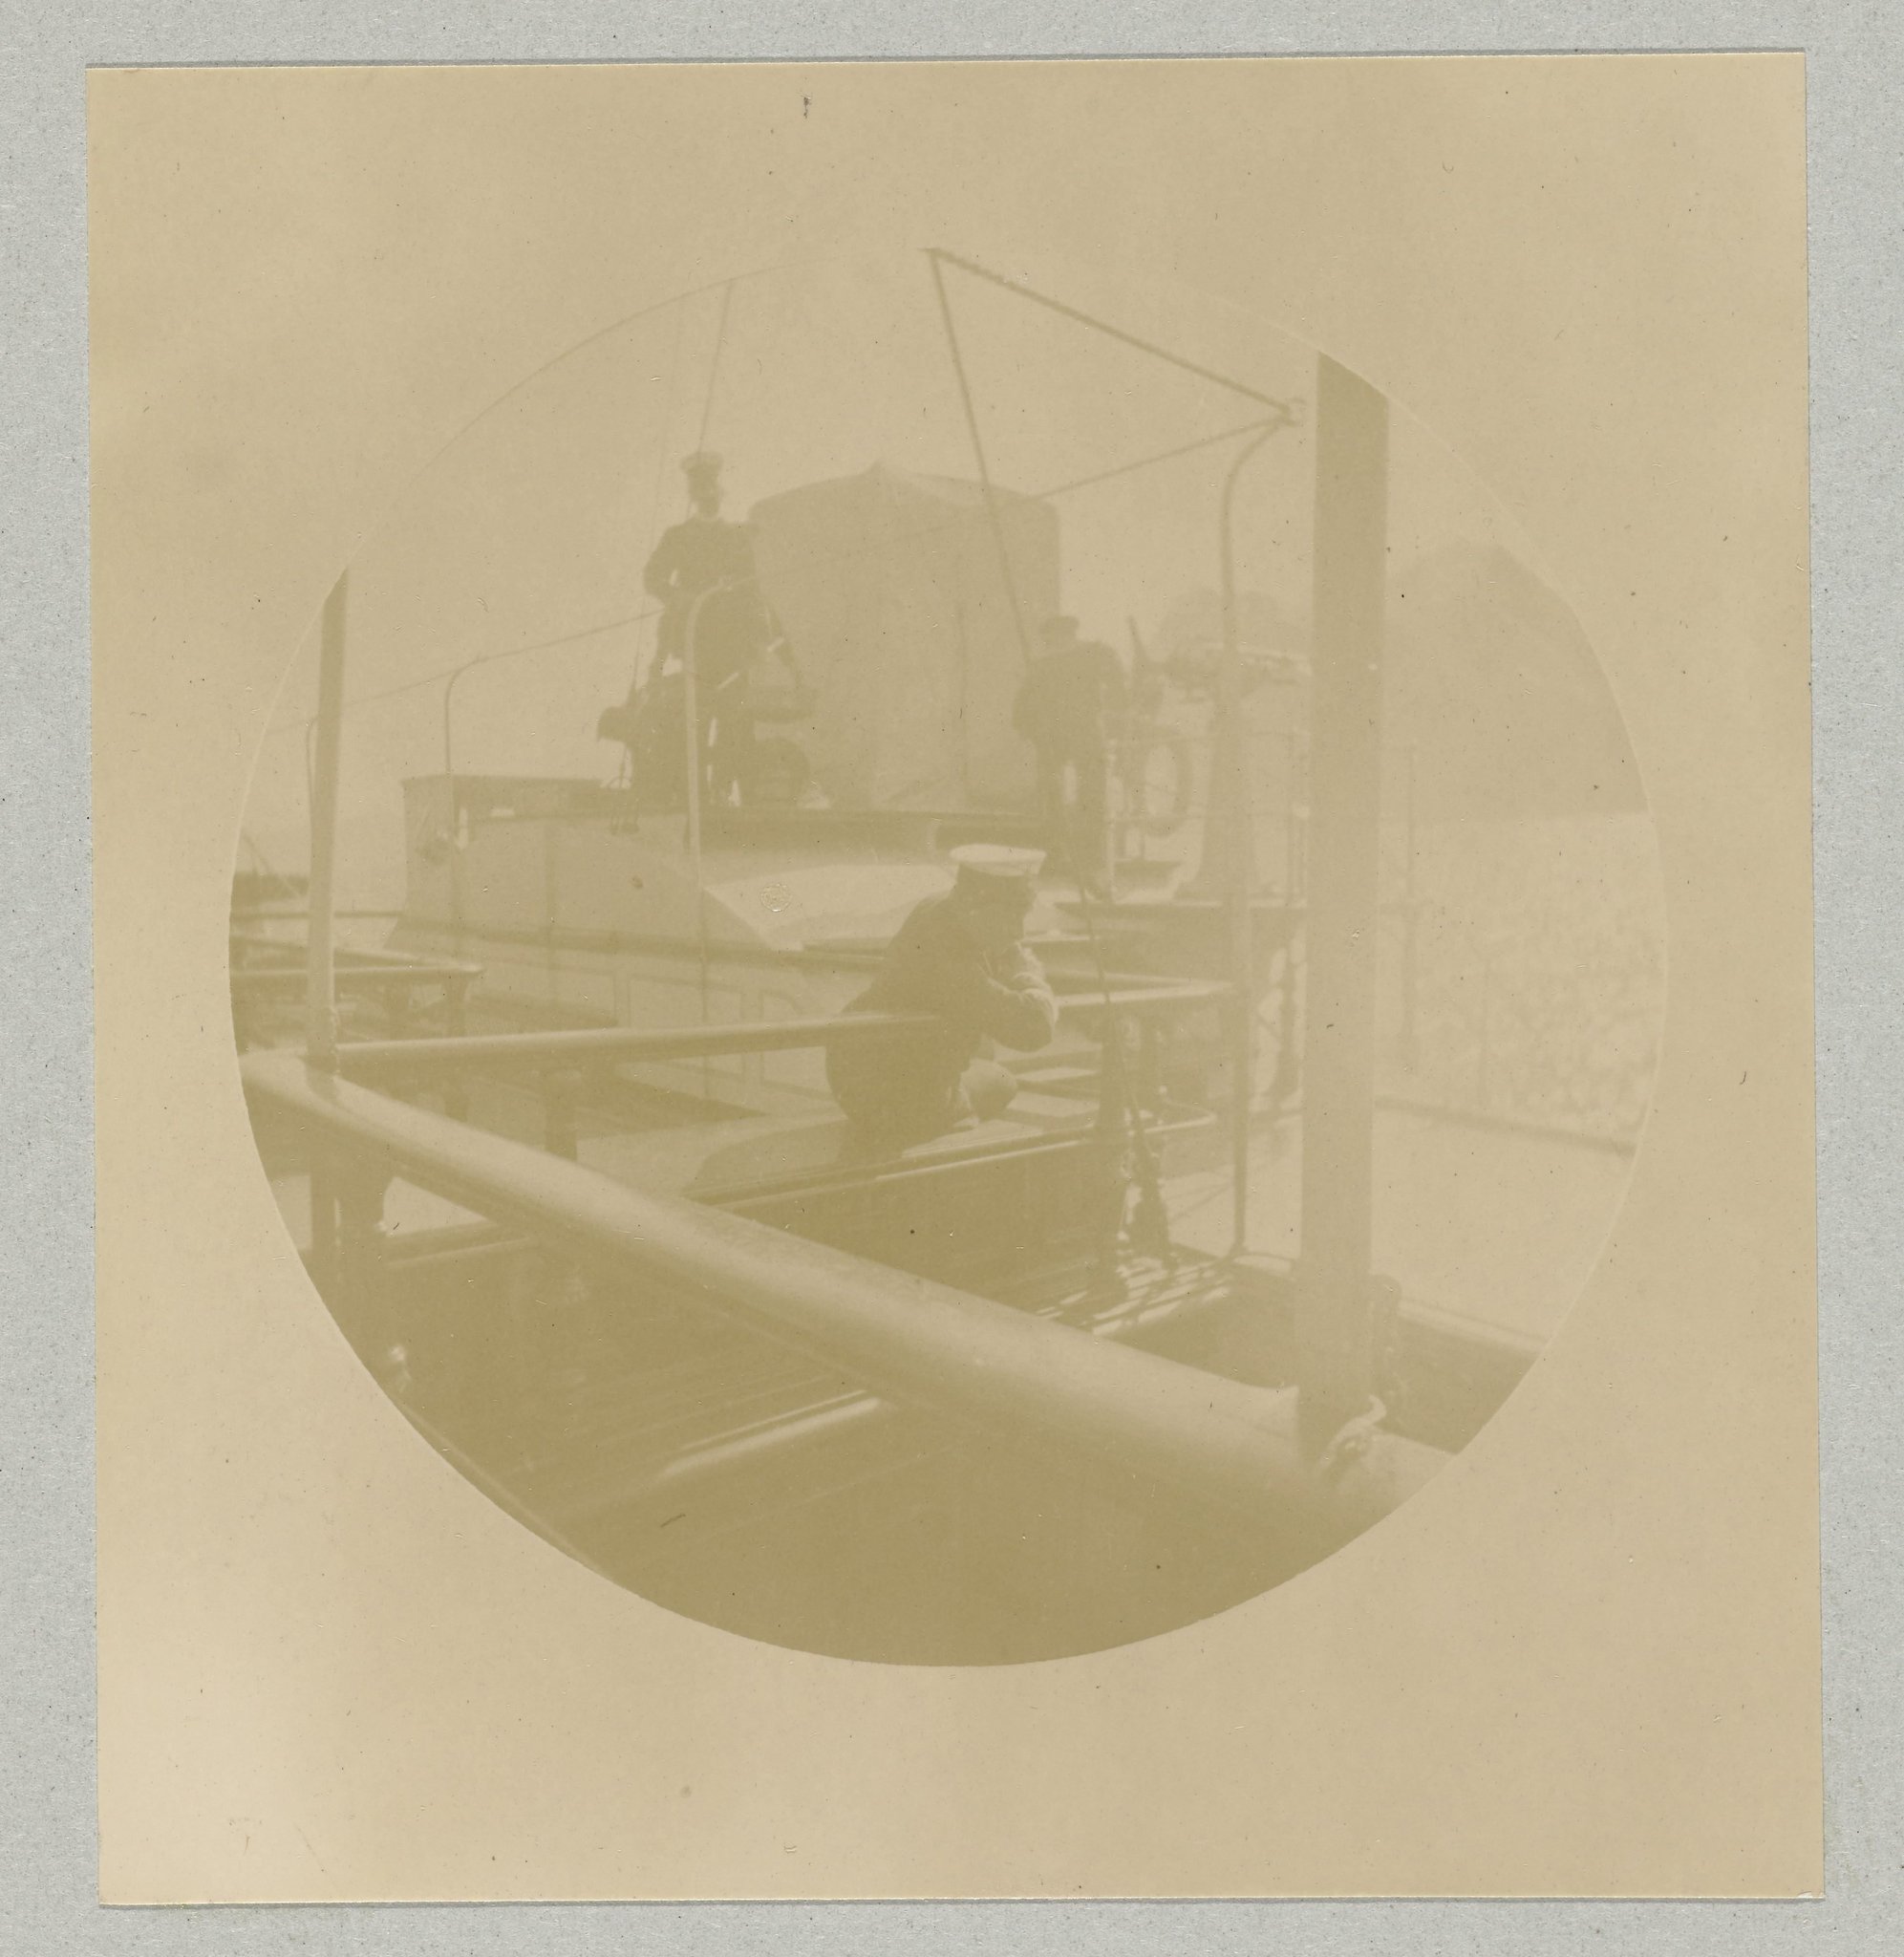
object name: photograph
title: Scheepspersoneel op het rad aan boord van de Hohenzollern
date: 1807-1889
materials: cardboard, paper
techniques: gelatin silver print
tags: wilhelm ii (keizer van duitsland), norway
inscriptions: number: ‘15’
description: De afdruk van de foto is rond, het papier vierkant. foto gemaakt met Nr. 1 Kodak Camera